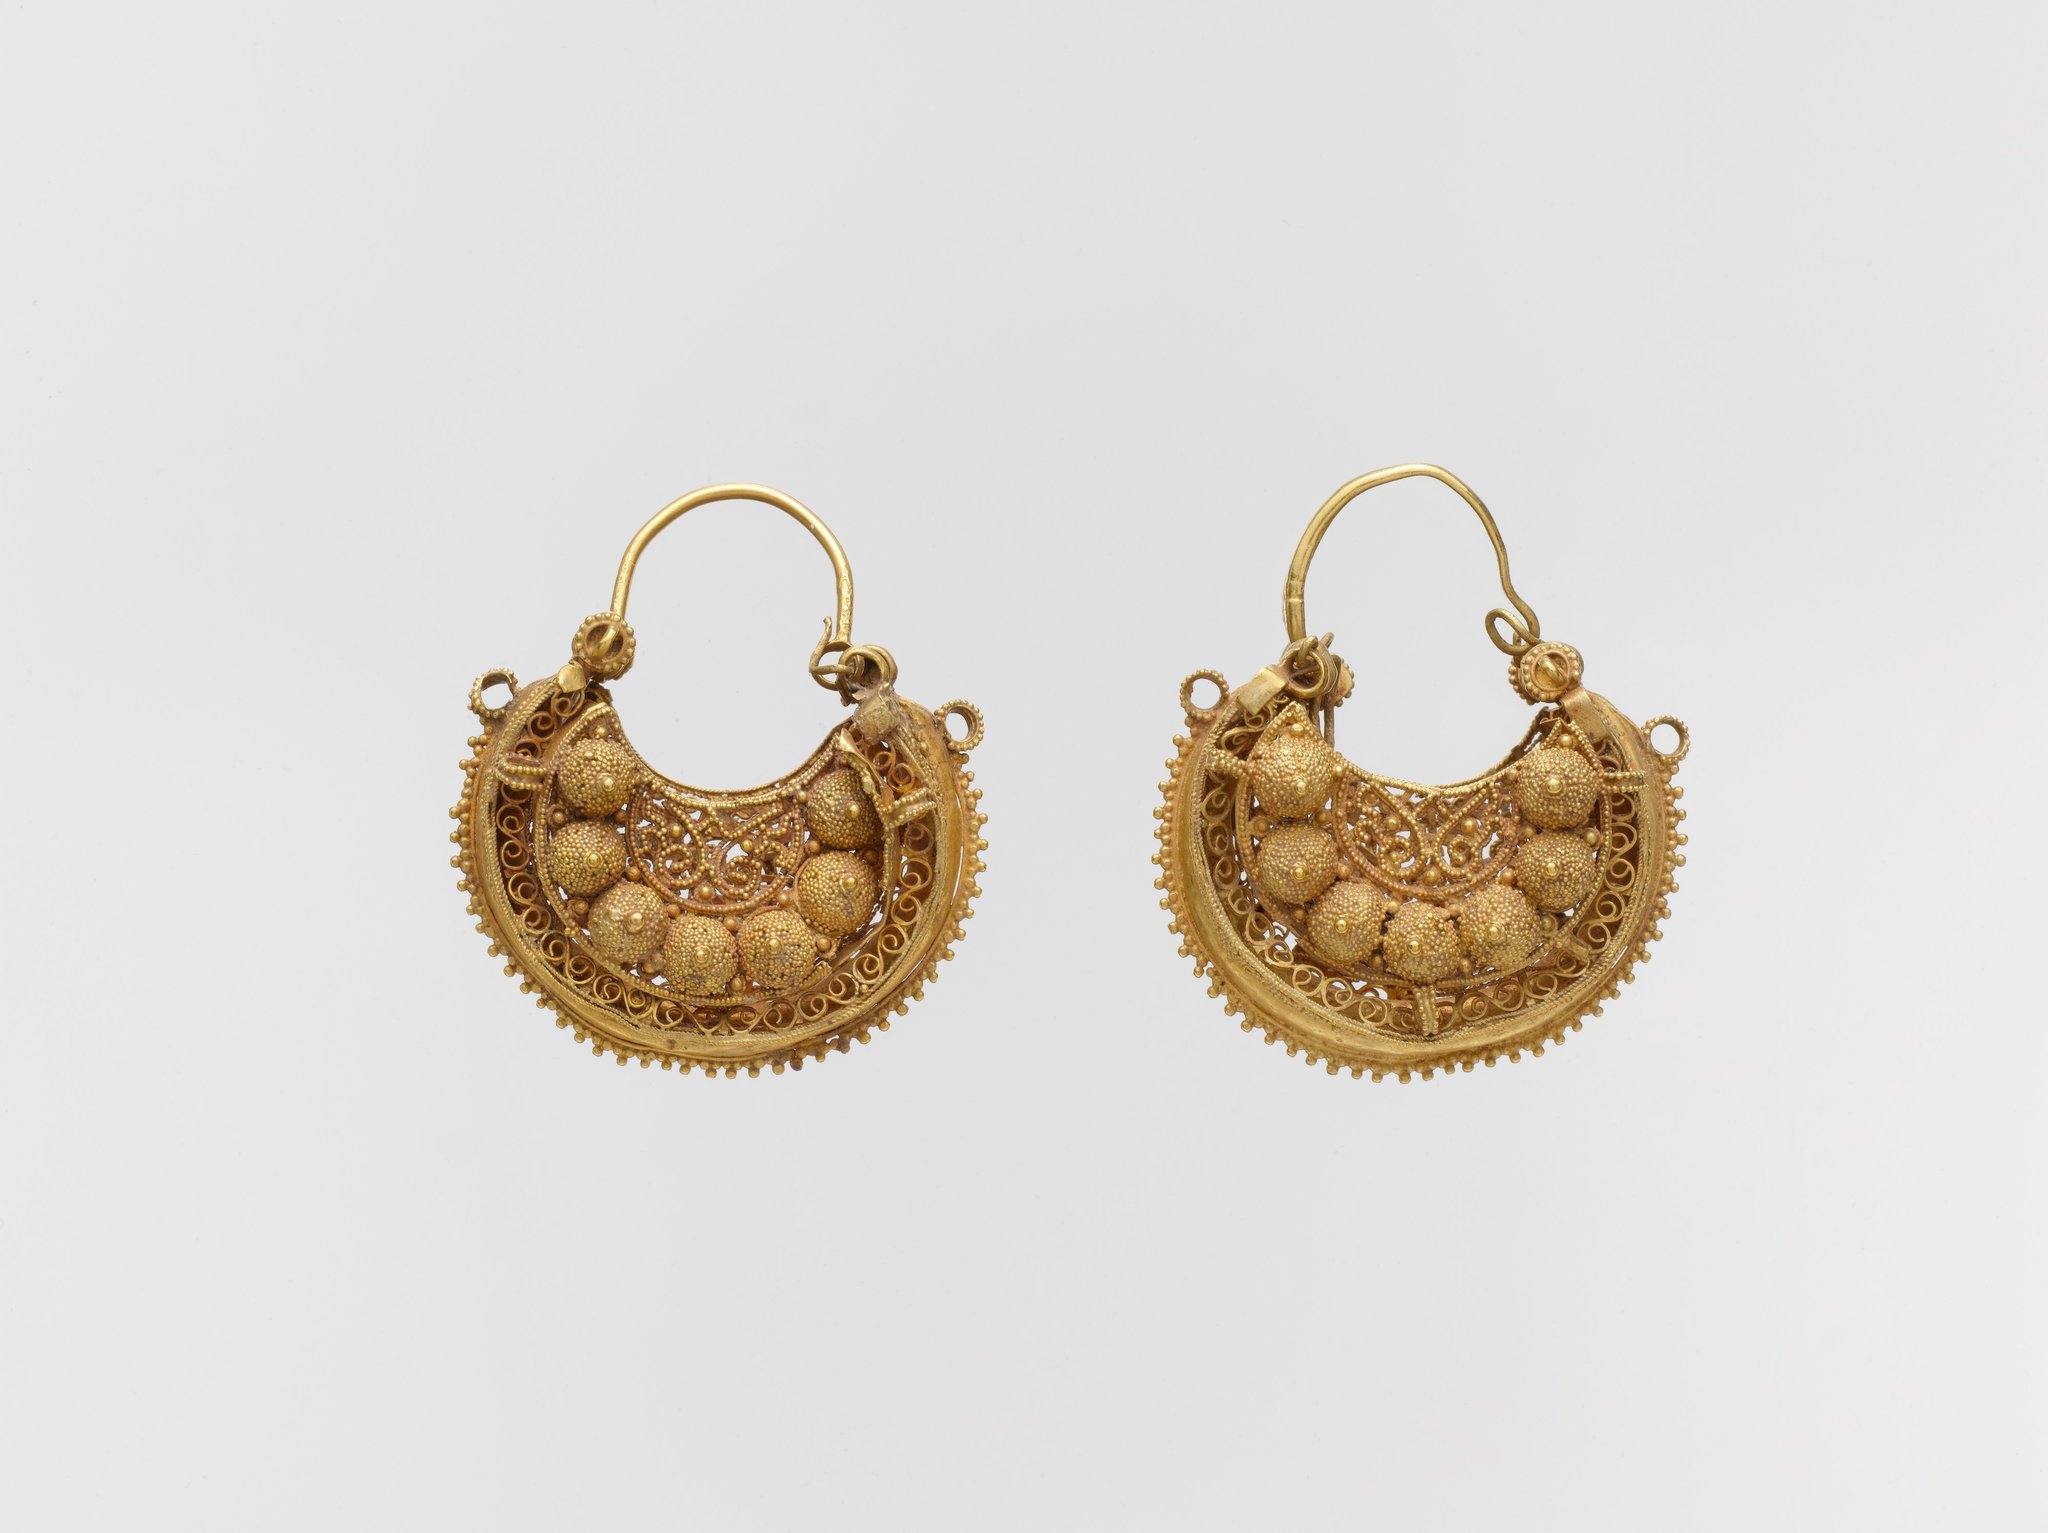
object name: earring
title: Pair of Earrings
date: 1001-1100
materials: gold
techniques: filigree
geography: syria